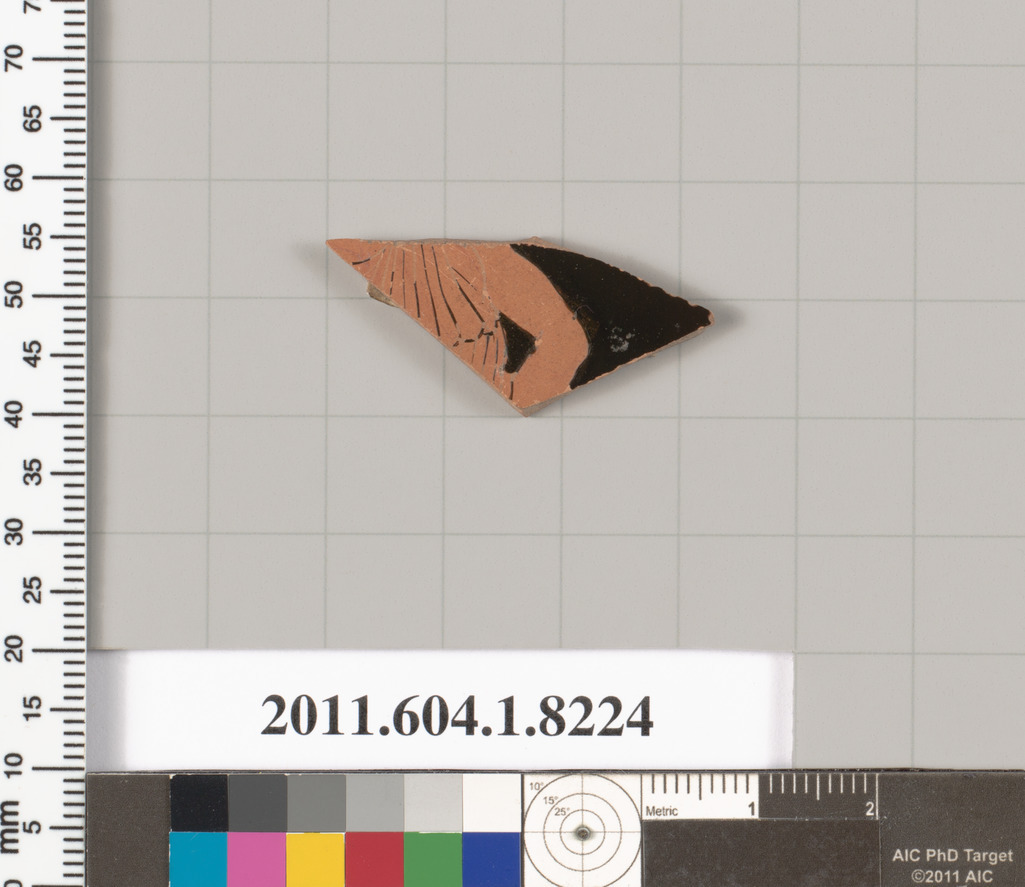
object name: kylix fragment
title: Terracotta fragment of a kylix (drinking cup)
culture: greek, attic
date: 520-510 BCE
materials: terracotta